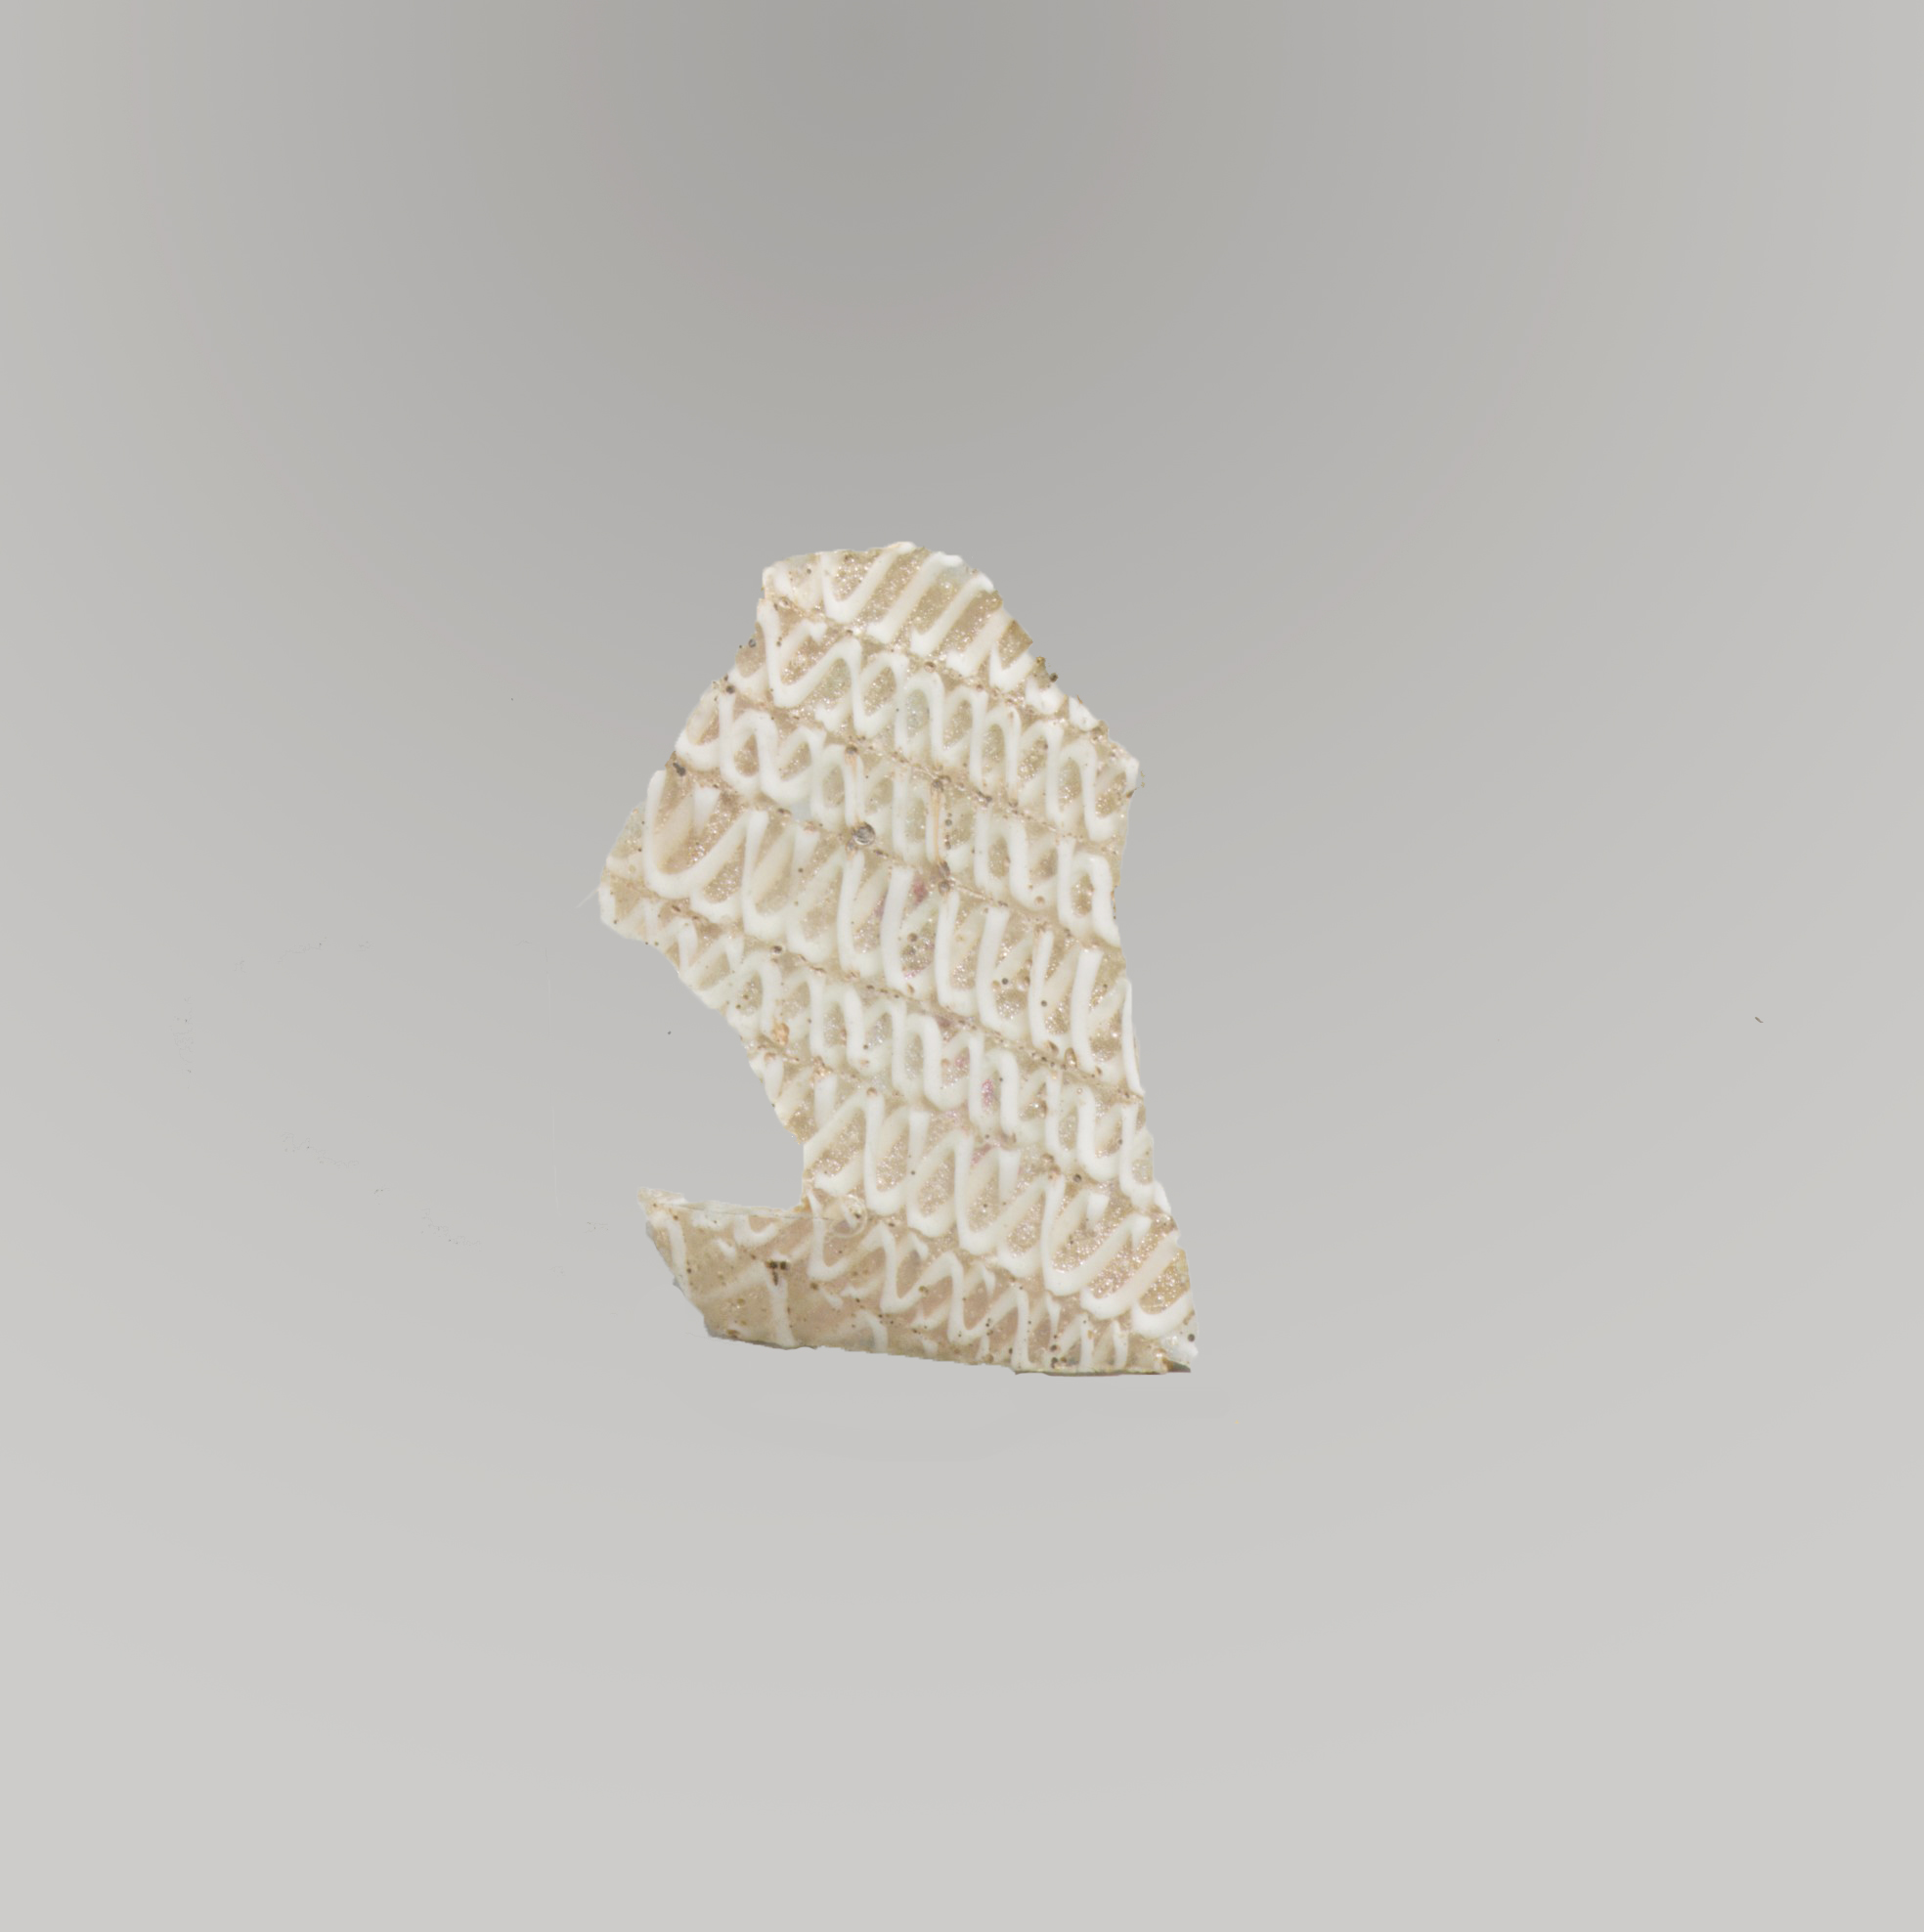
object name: fragment, network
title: Glass network mosaic fragment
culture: roman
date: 34 BCE-33 CE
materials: glass